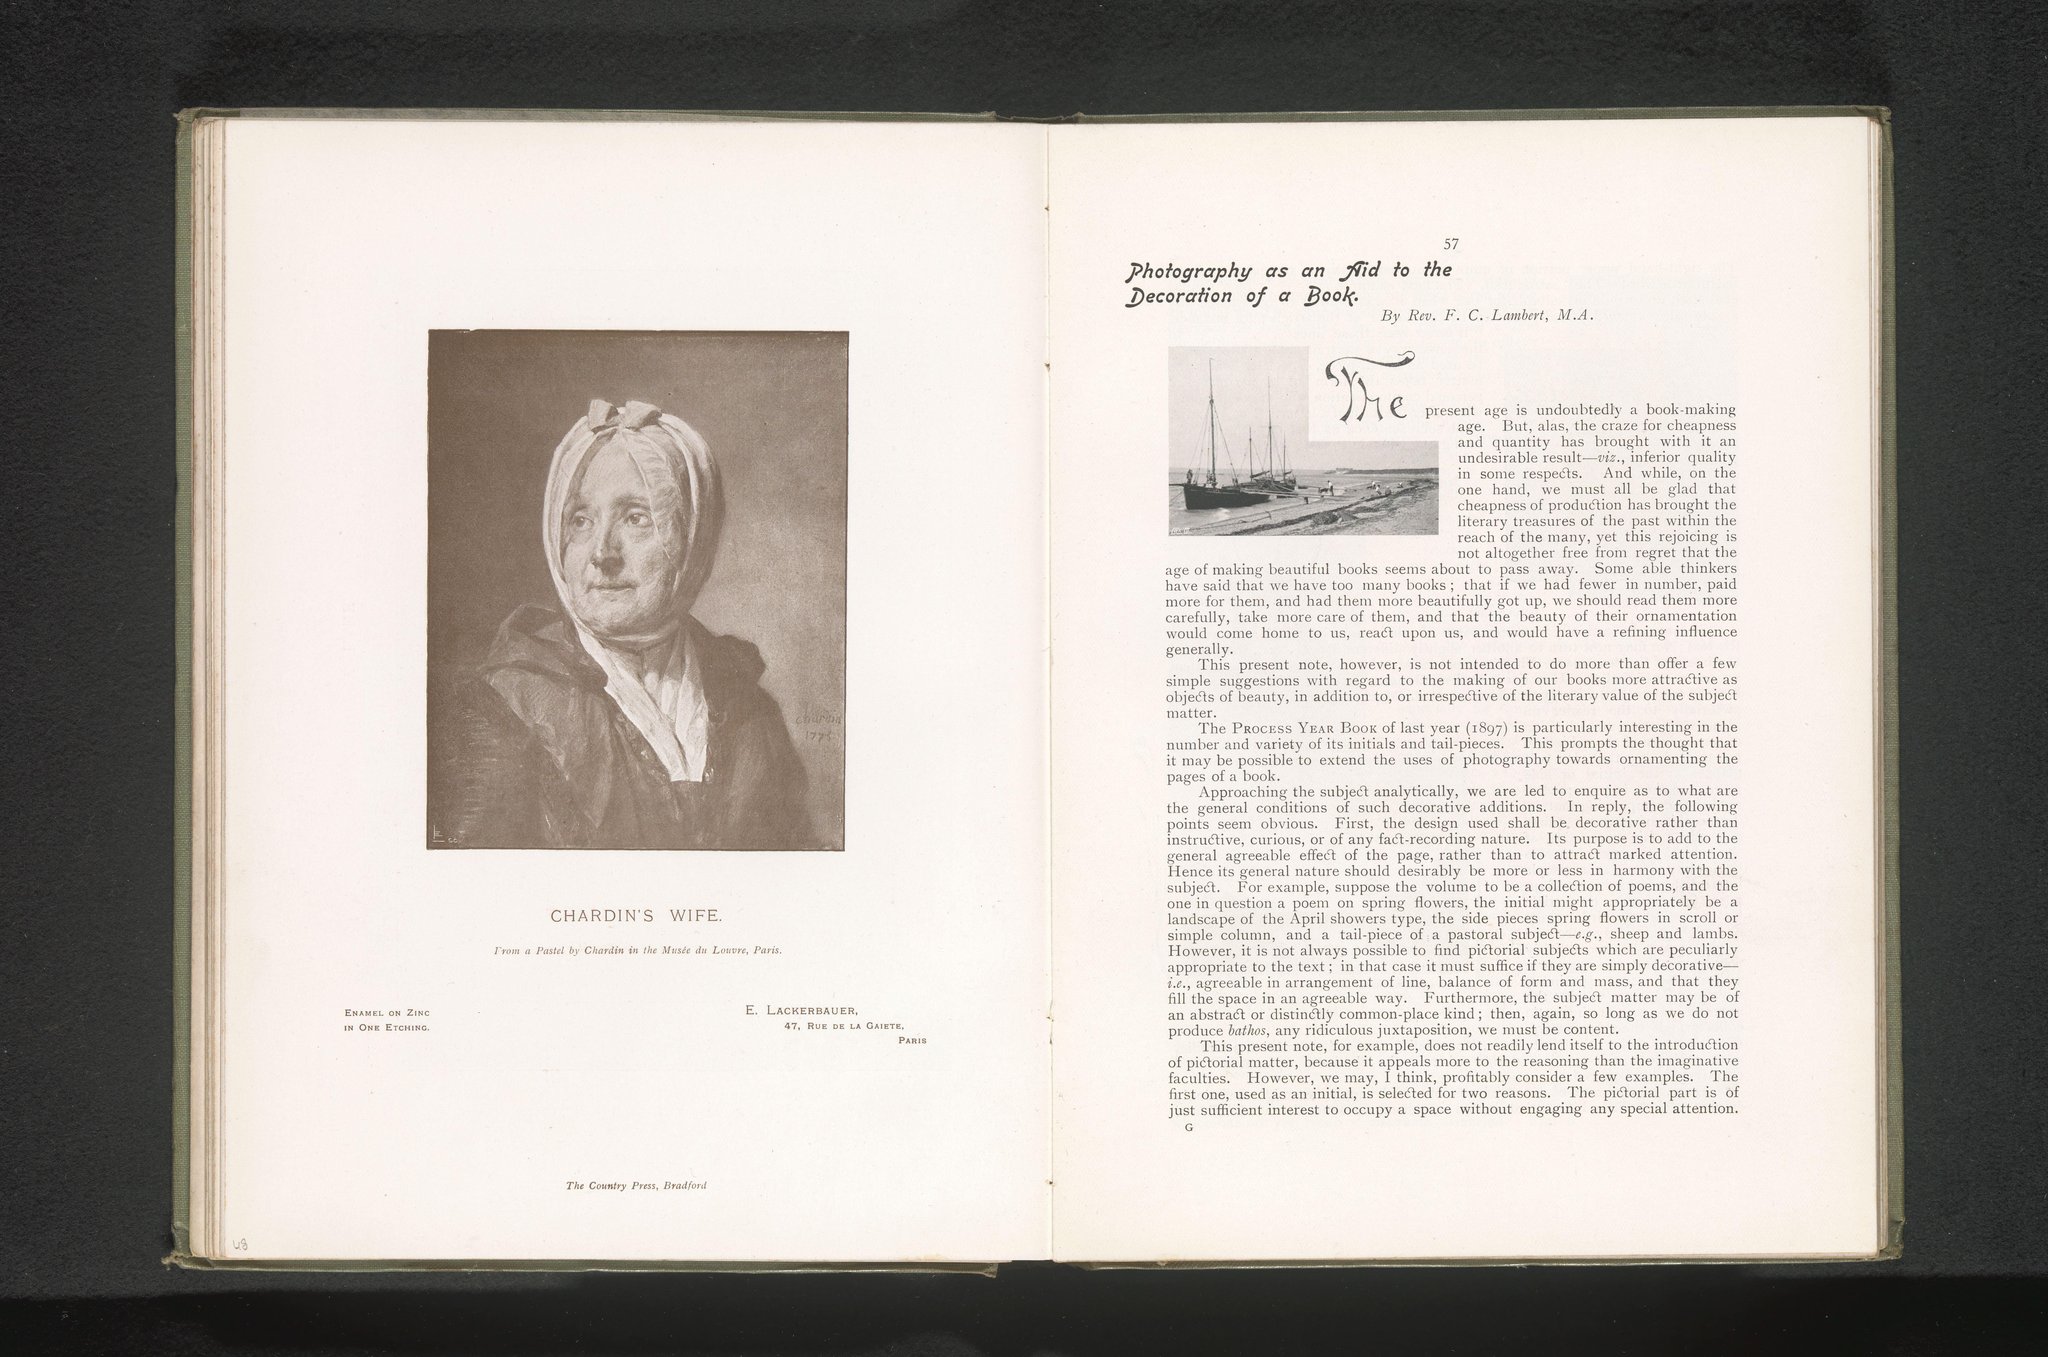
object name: photomechanical print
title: Reproductie van Portrait de Madame Chardin door Jean Baptiste Siméon Chardin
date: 1893-1898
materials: paper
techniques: autotype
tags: historical persons - bb - woman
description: Prent op vierde ongenummerde pagina na pagina 56.